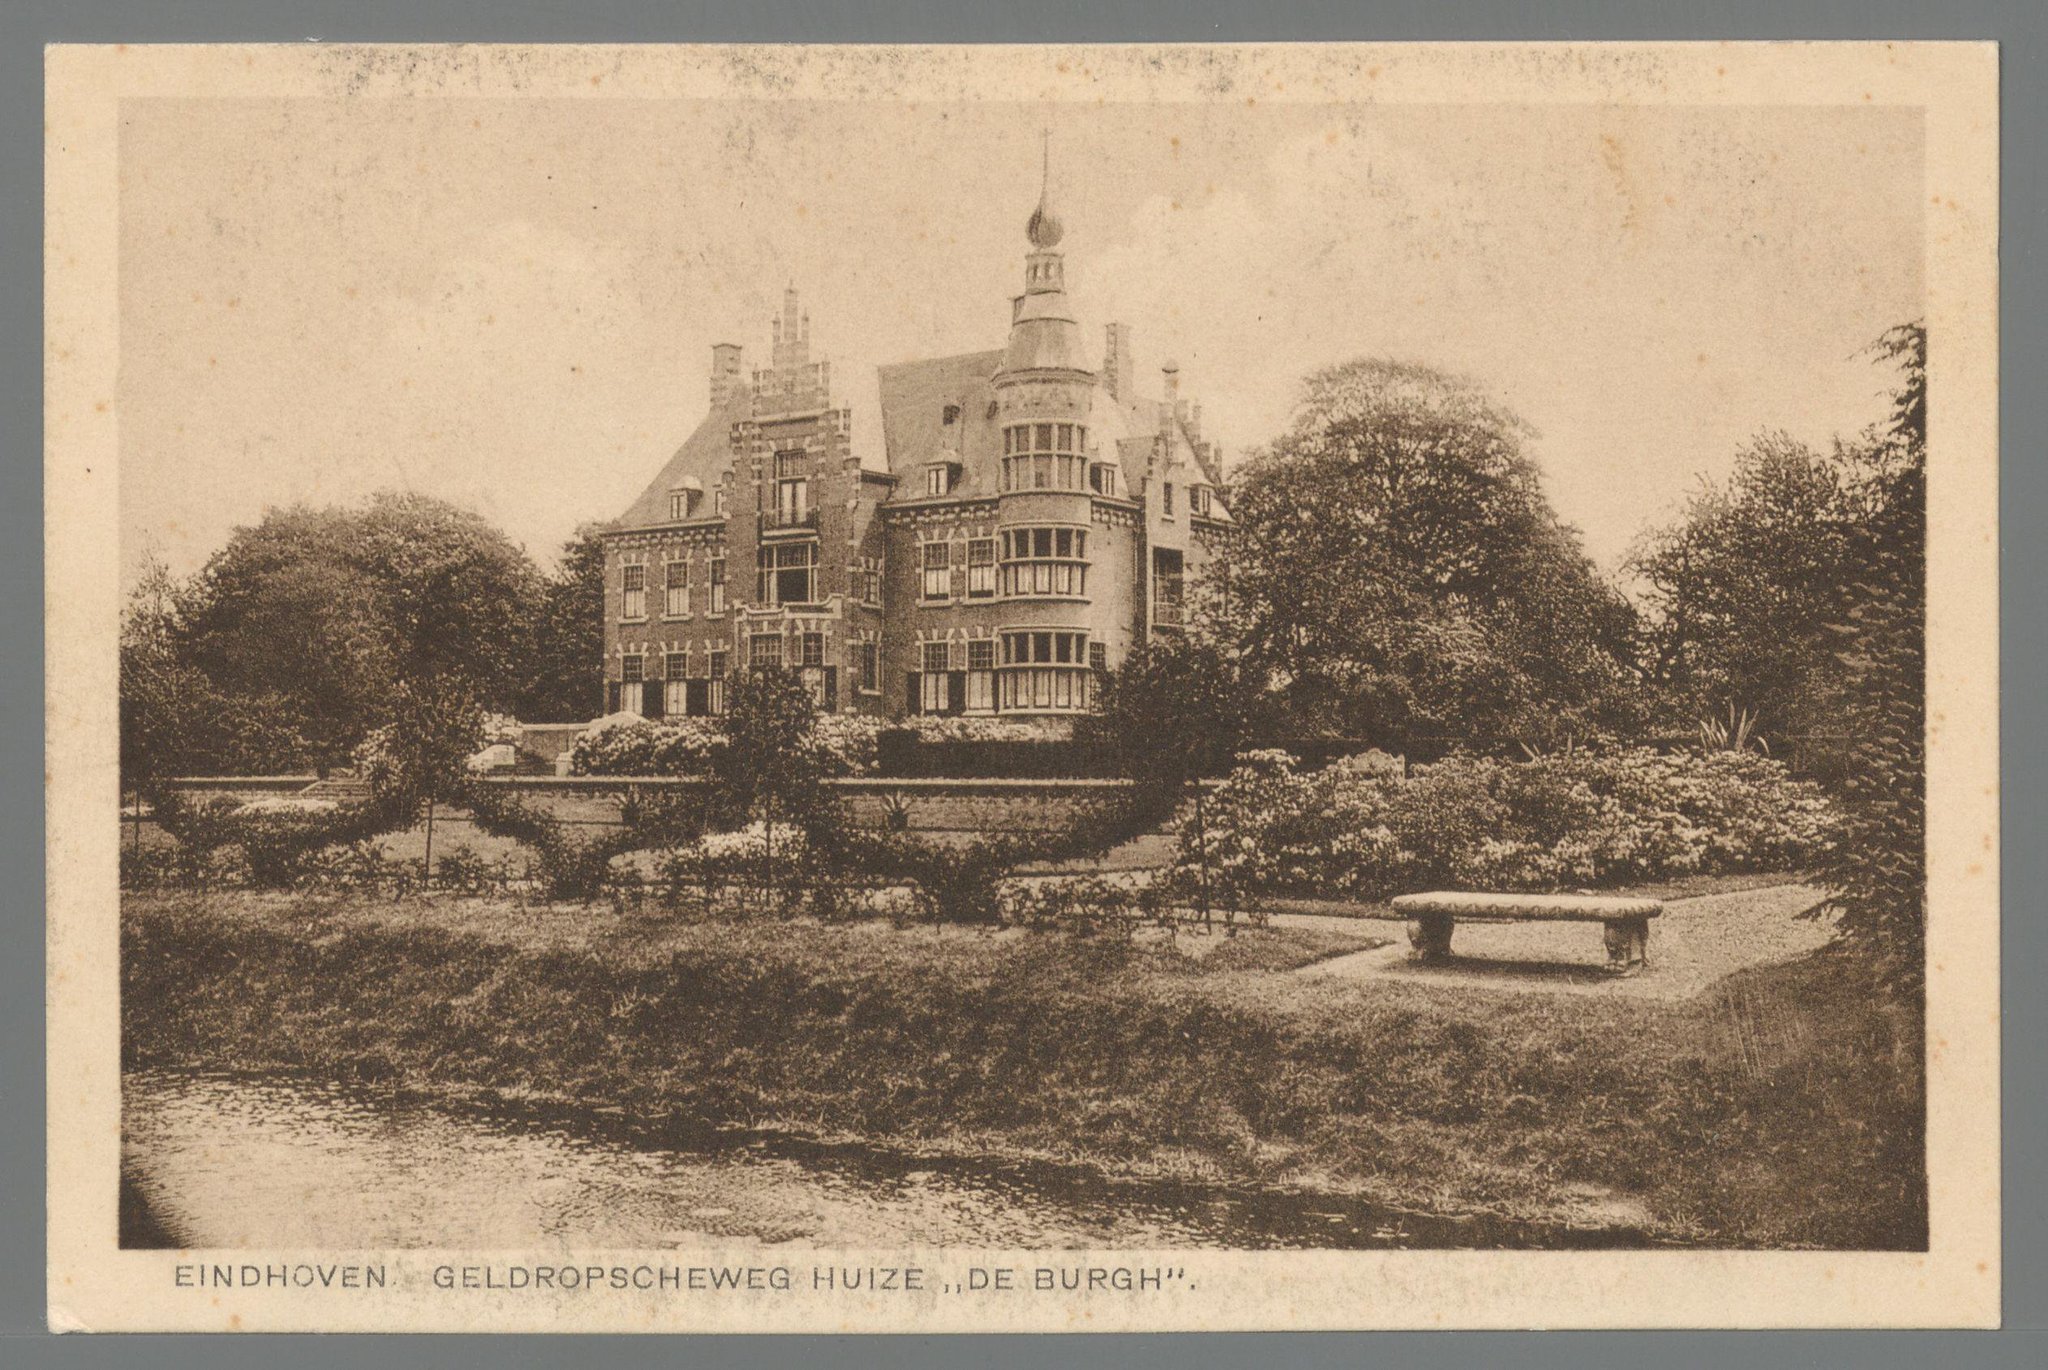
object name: photomechanical print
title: Eindhoven. Geldropscheweg Huize "De Burgh"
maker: Anonymous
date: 1923-1950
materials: cardboard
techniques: photograph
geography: eindhoven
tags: villa